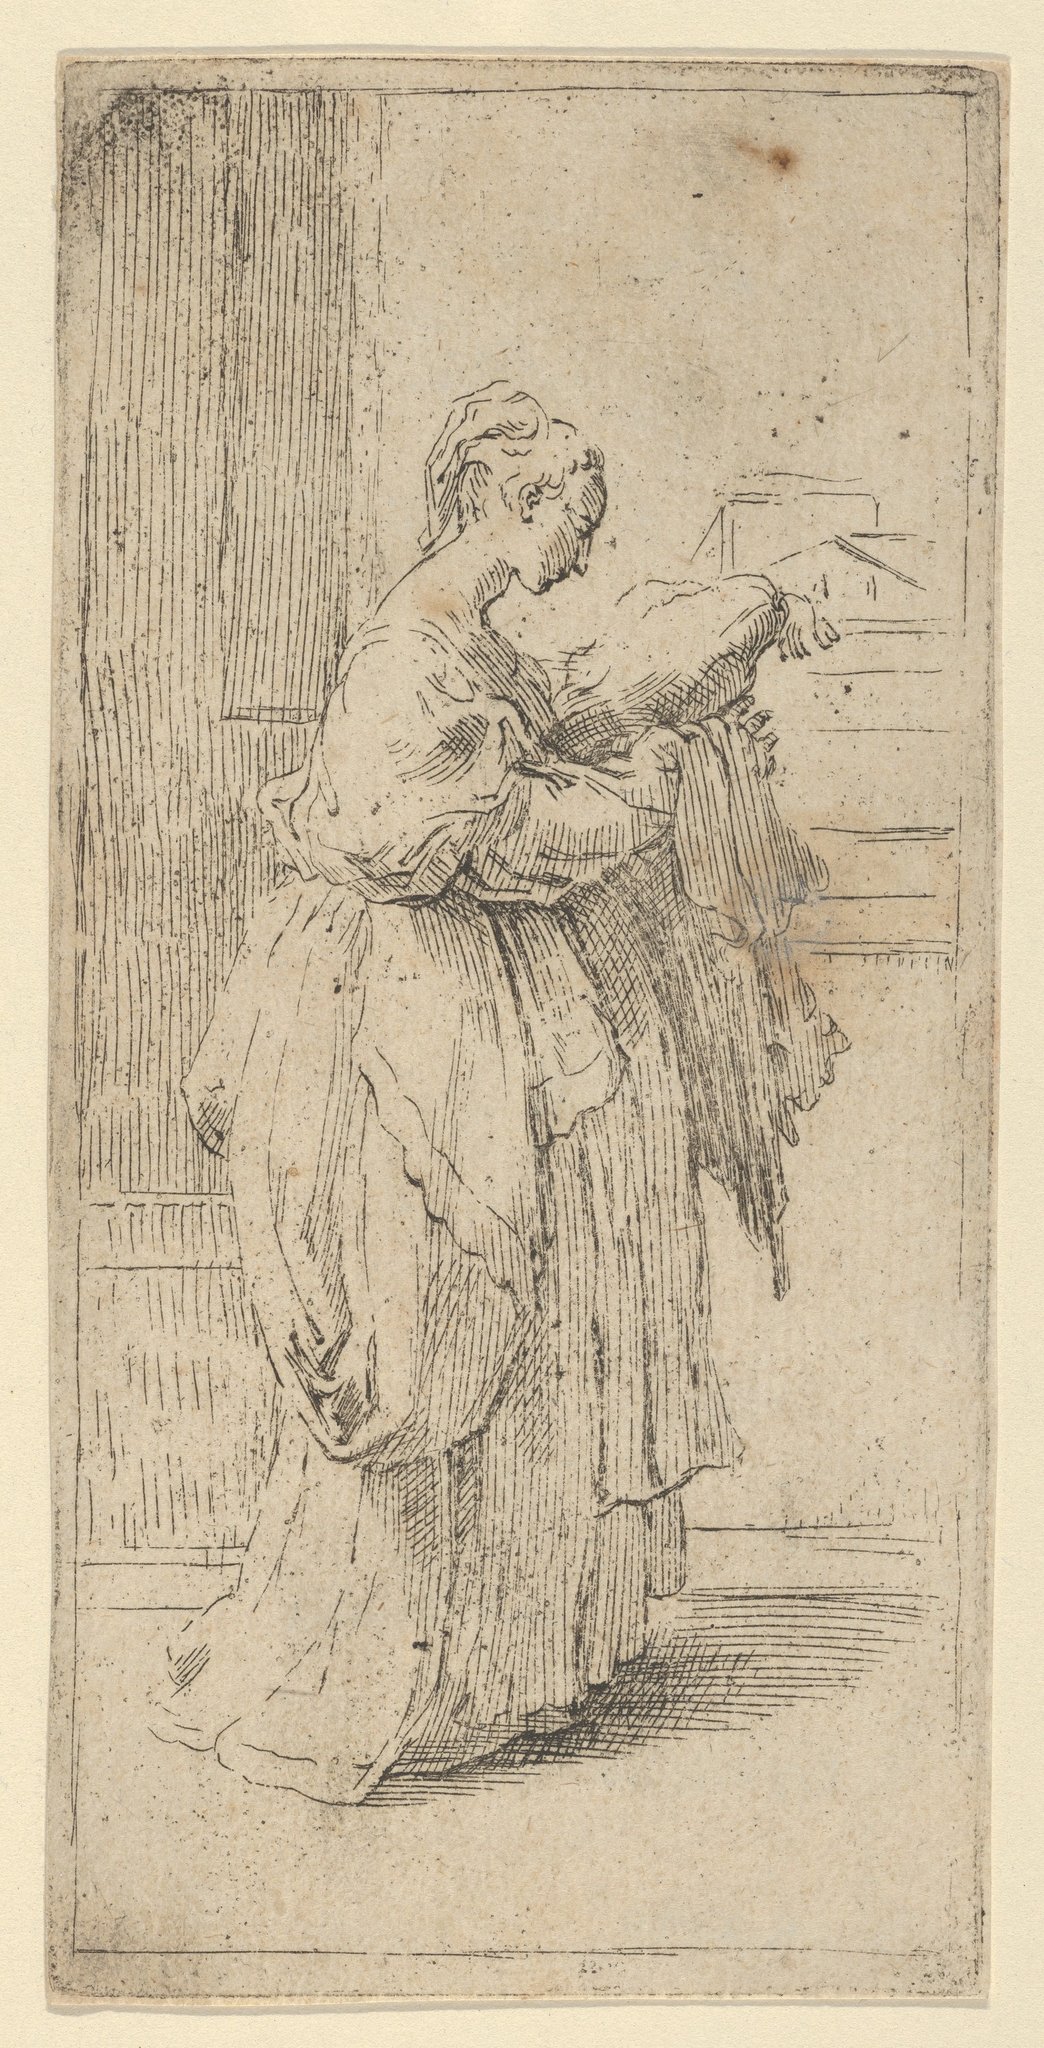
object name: print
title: Girl carrying a cushion, seen in profile facing right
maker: guido reni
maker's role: artist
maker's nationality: italian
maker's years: 1575-1642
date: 1590-1690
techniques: etching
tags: girls